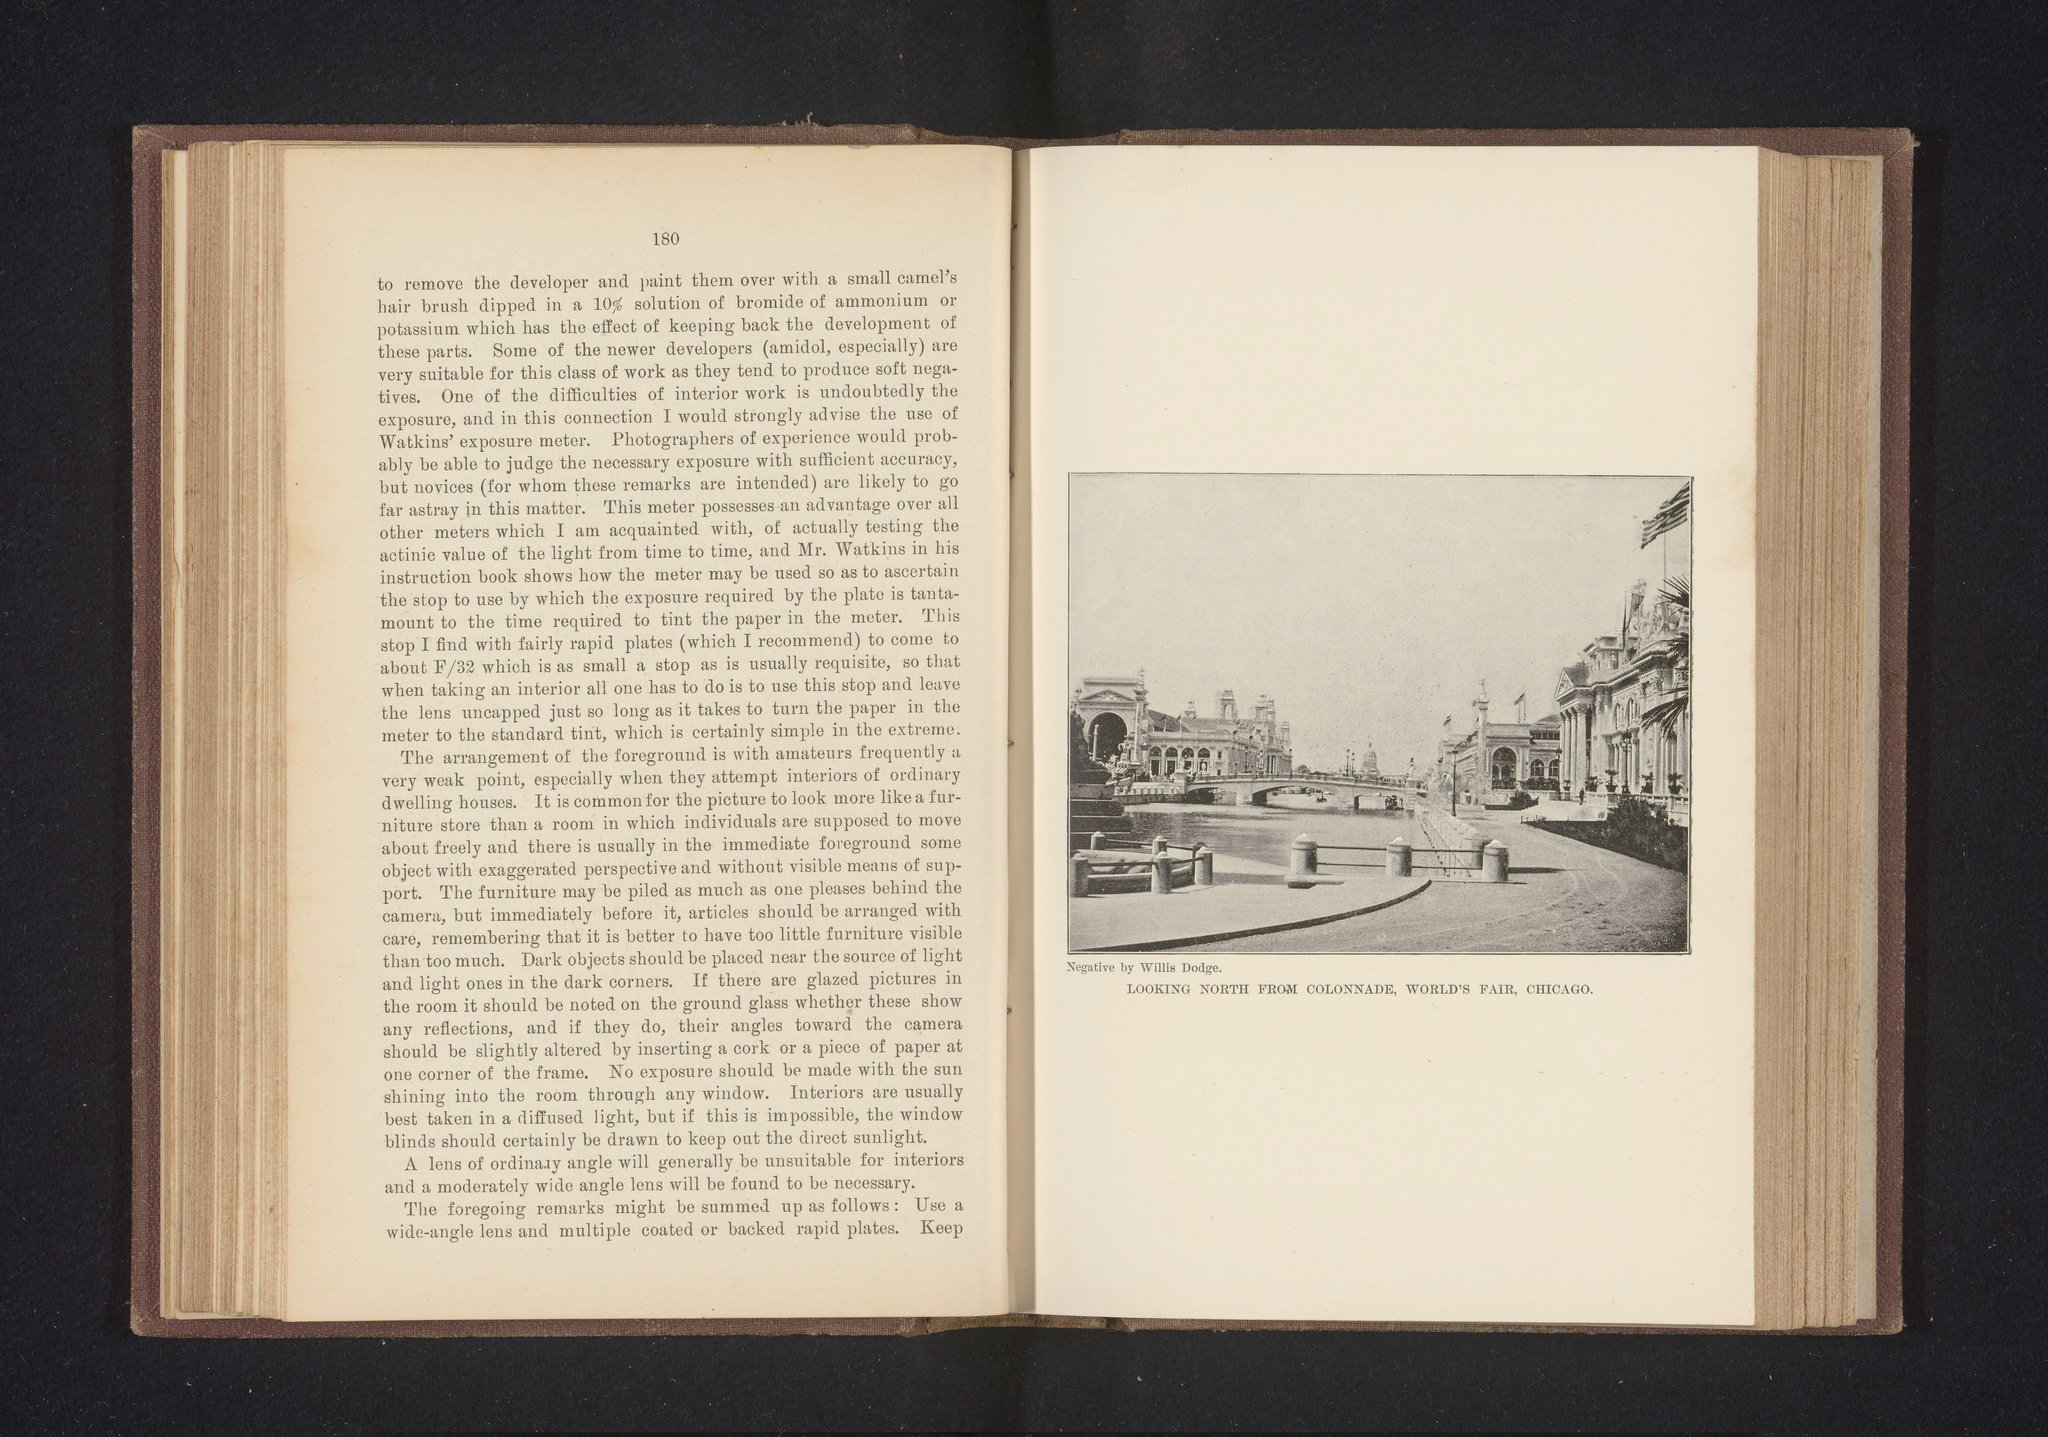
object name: photomechanical print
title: Looking north from colonnade, world's fair, Chicago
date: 1893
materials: paper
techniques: autotype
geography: chicago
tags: world fair, world exhibition